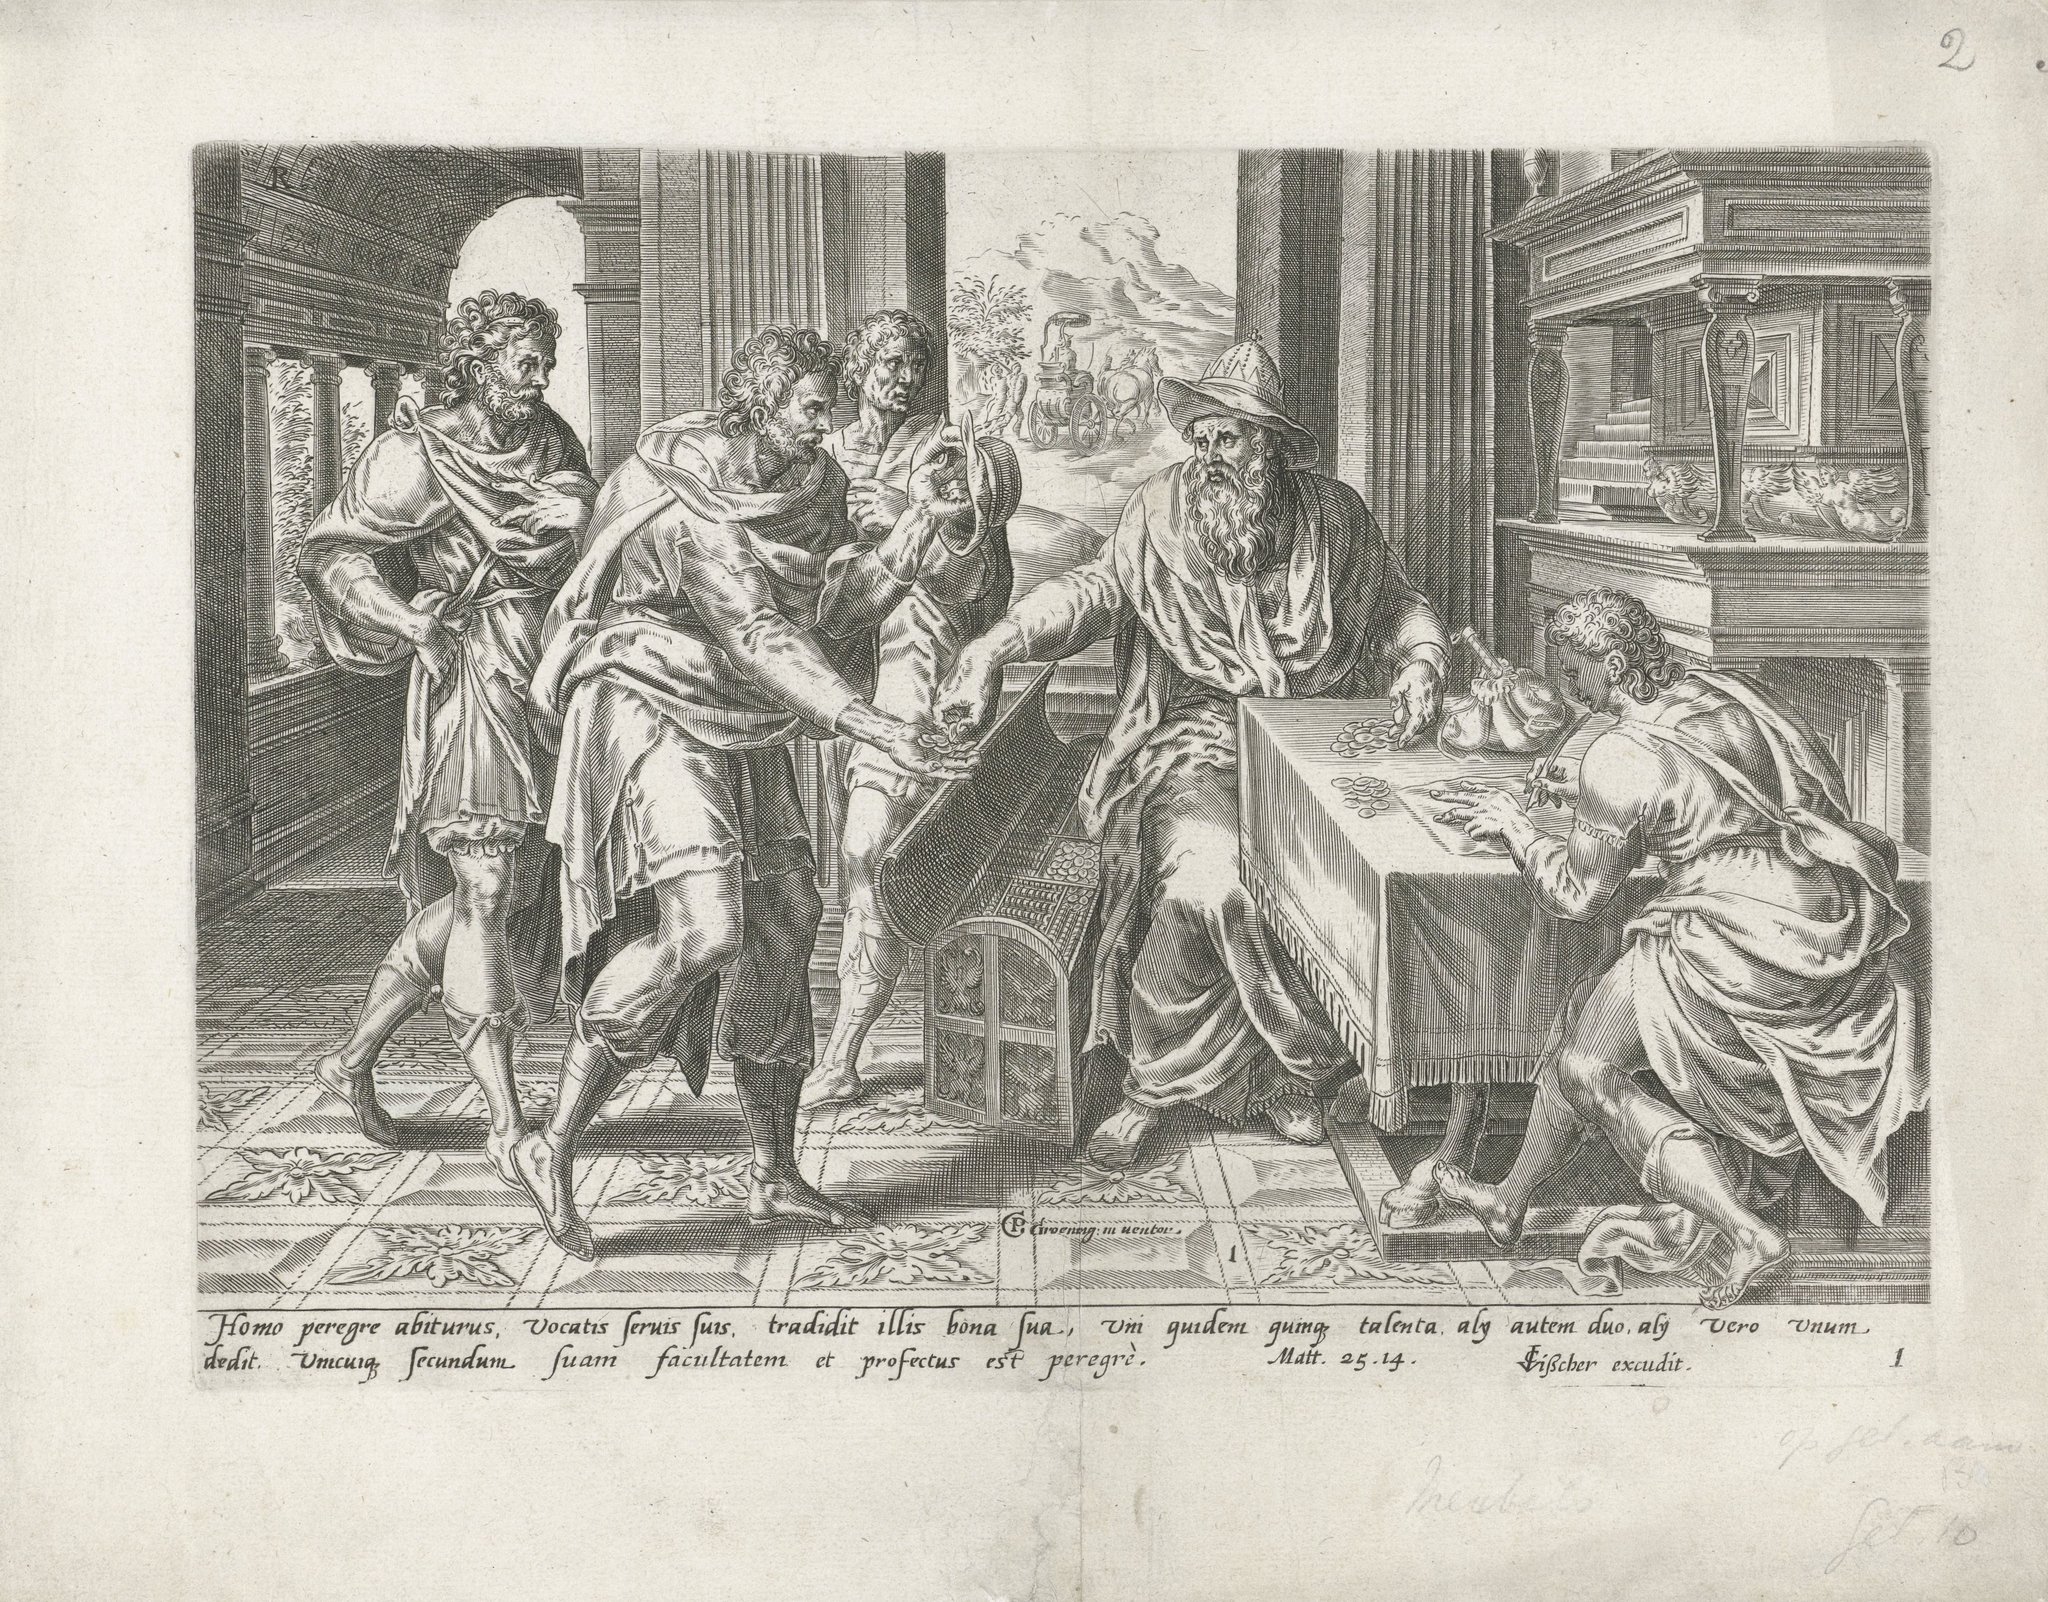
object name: print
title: Man geeft talenten aan zijn dienaren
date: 1565-1572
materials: paper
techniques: engraving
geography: amsterdam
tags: the lord distributing talents or pounds among his servants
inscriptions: collector's mark: Lugt 2228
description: Prent mogelijk gebruikt in: Piscator, Nicolaus Johannes. Theatrum biblicum hoc est Historiæ sacræ Veteris et Novi Testamenti tabulis æneis expressæ. Amsterdam: Claes Jansz. Visscher, 1639 en 1643, Amsterdam: Nicolaes Visscher, 1674. Of in: Schabaelje, Jan Philipsz. Den grooten figver-bibel. Dat is een afbeeldingh en levendighe vertooningh, van alle de voornaemste historien (...) der gantscher Heyliger Schrift, in schoone copere figueren (...) verrijckt met leersame verclaeringhen over de selve figueren. Alkmaar: Simon Cornelisz Brekegeest, Amsterdam: Jan Philipsz. Schabaelje, 1646.